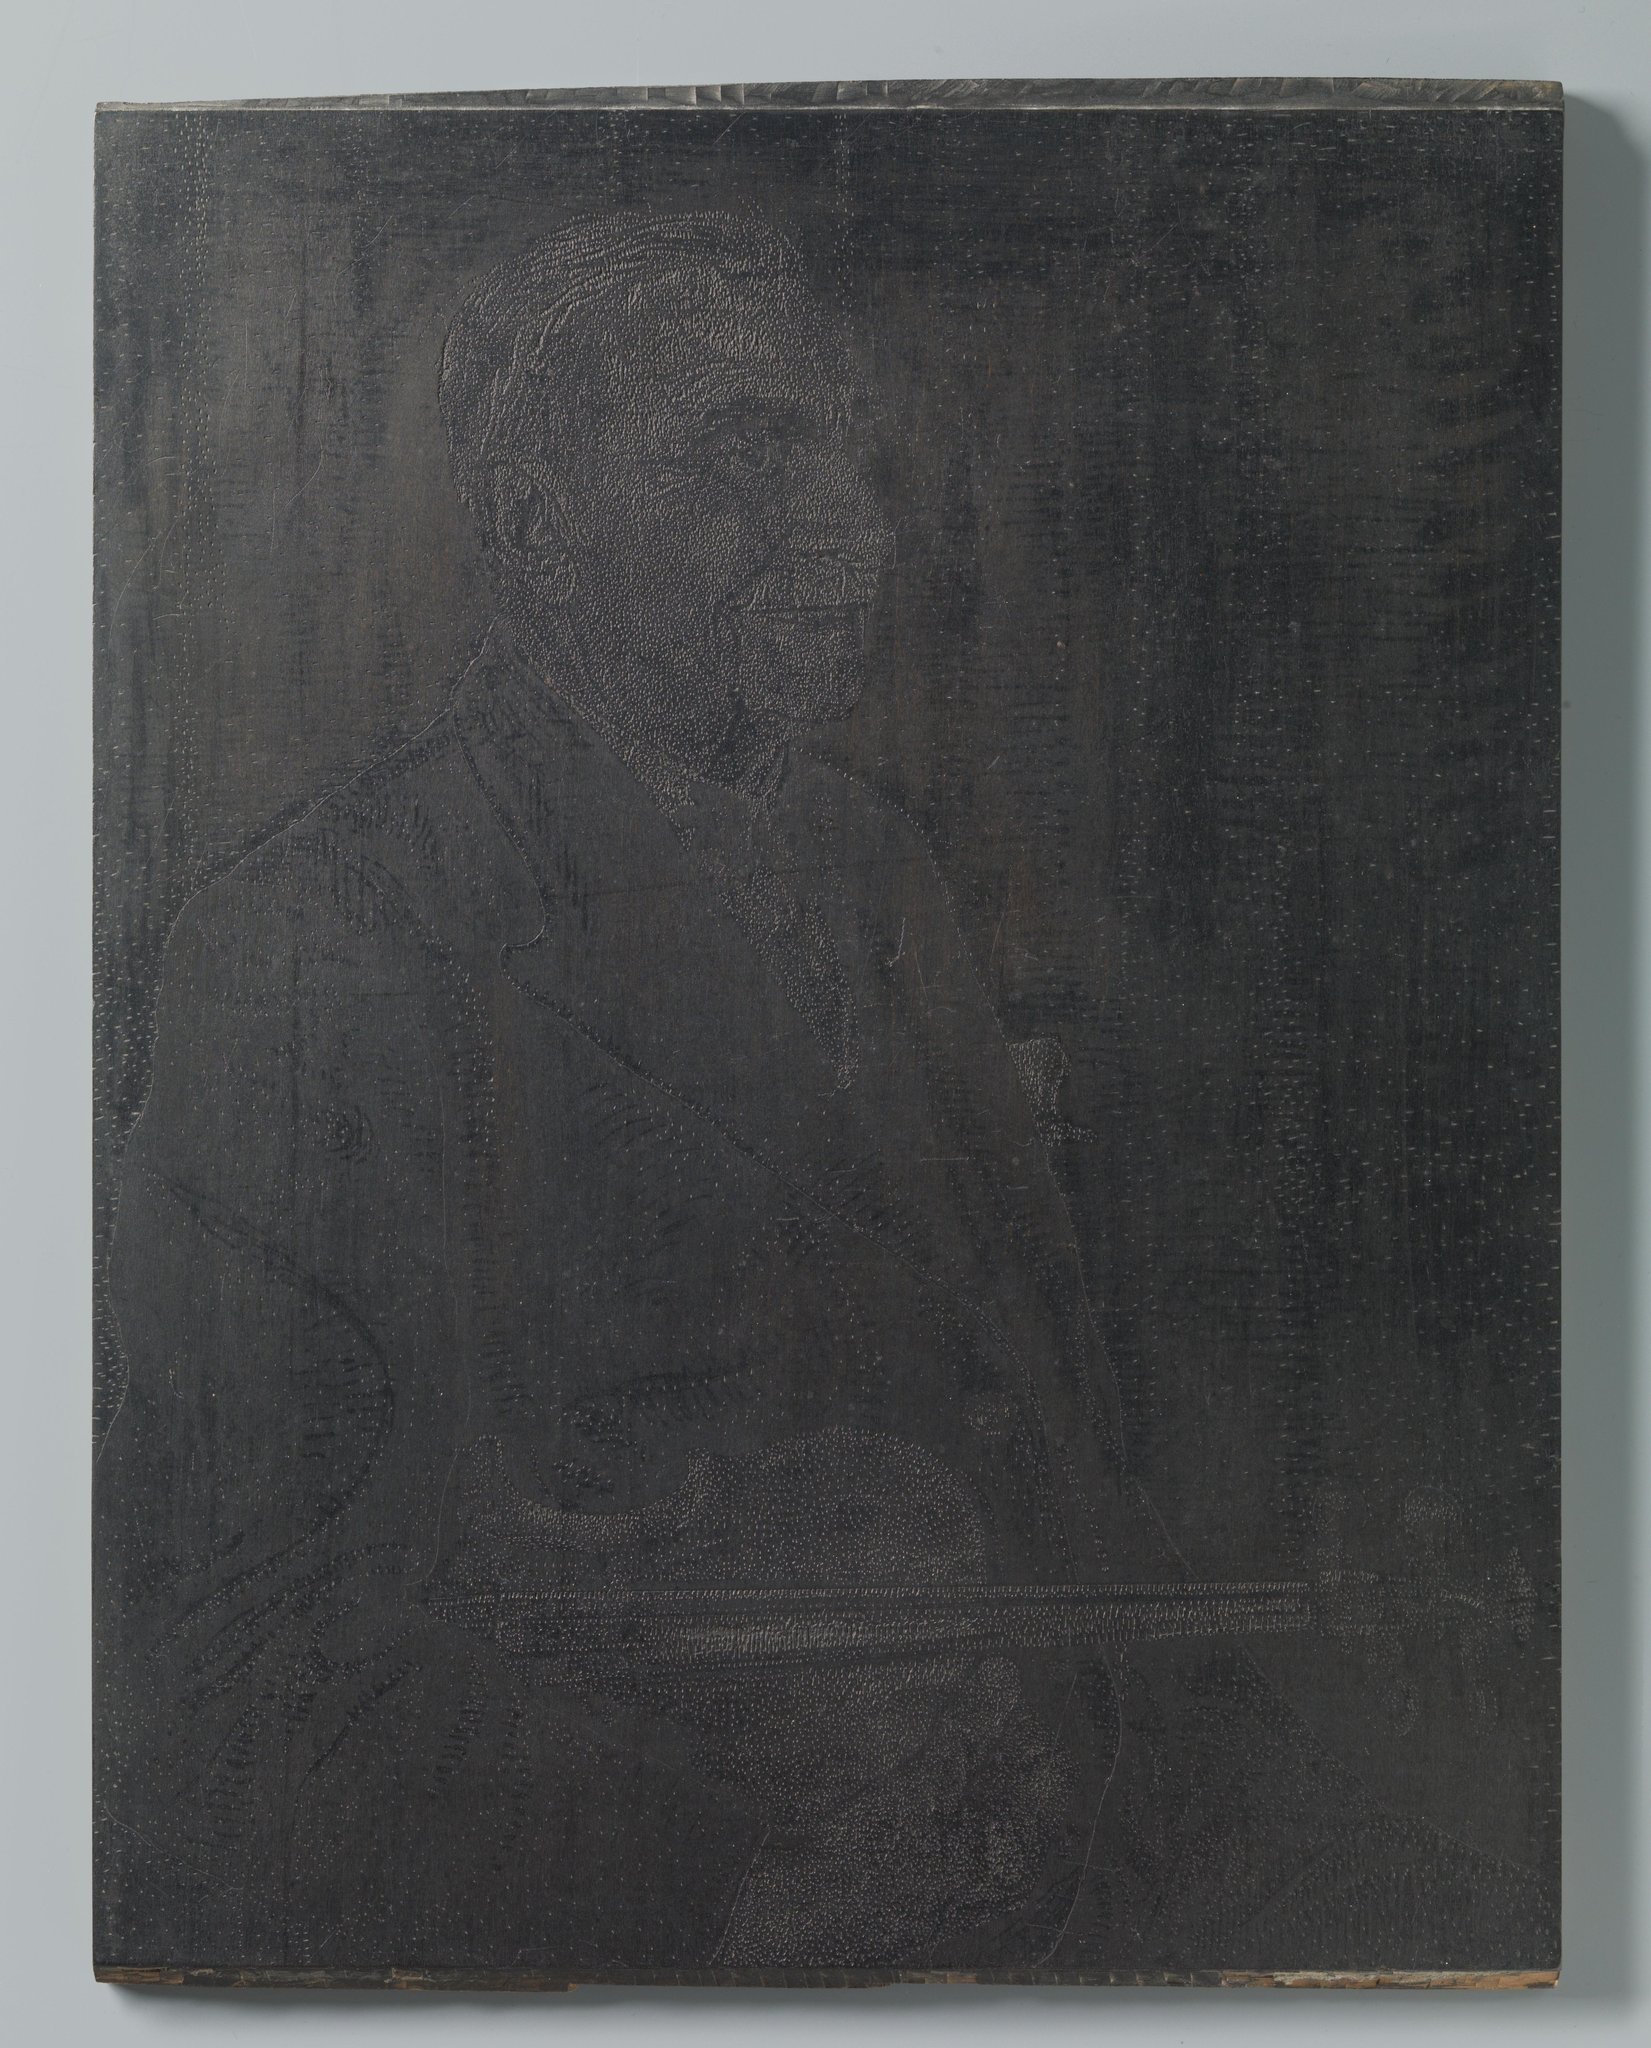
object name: wood block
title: De vader van de kunstenaar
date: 1916-1947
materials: wood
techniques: woodcut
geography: netherlands